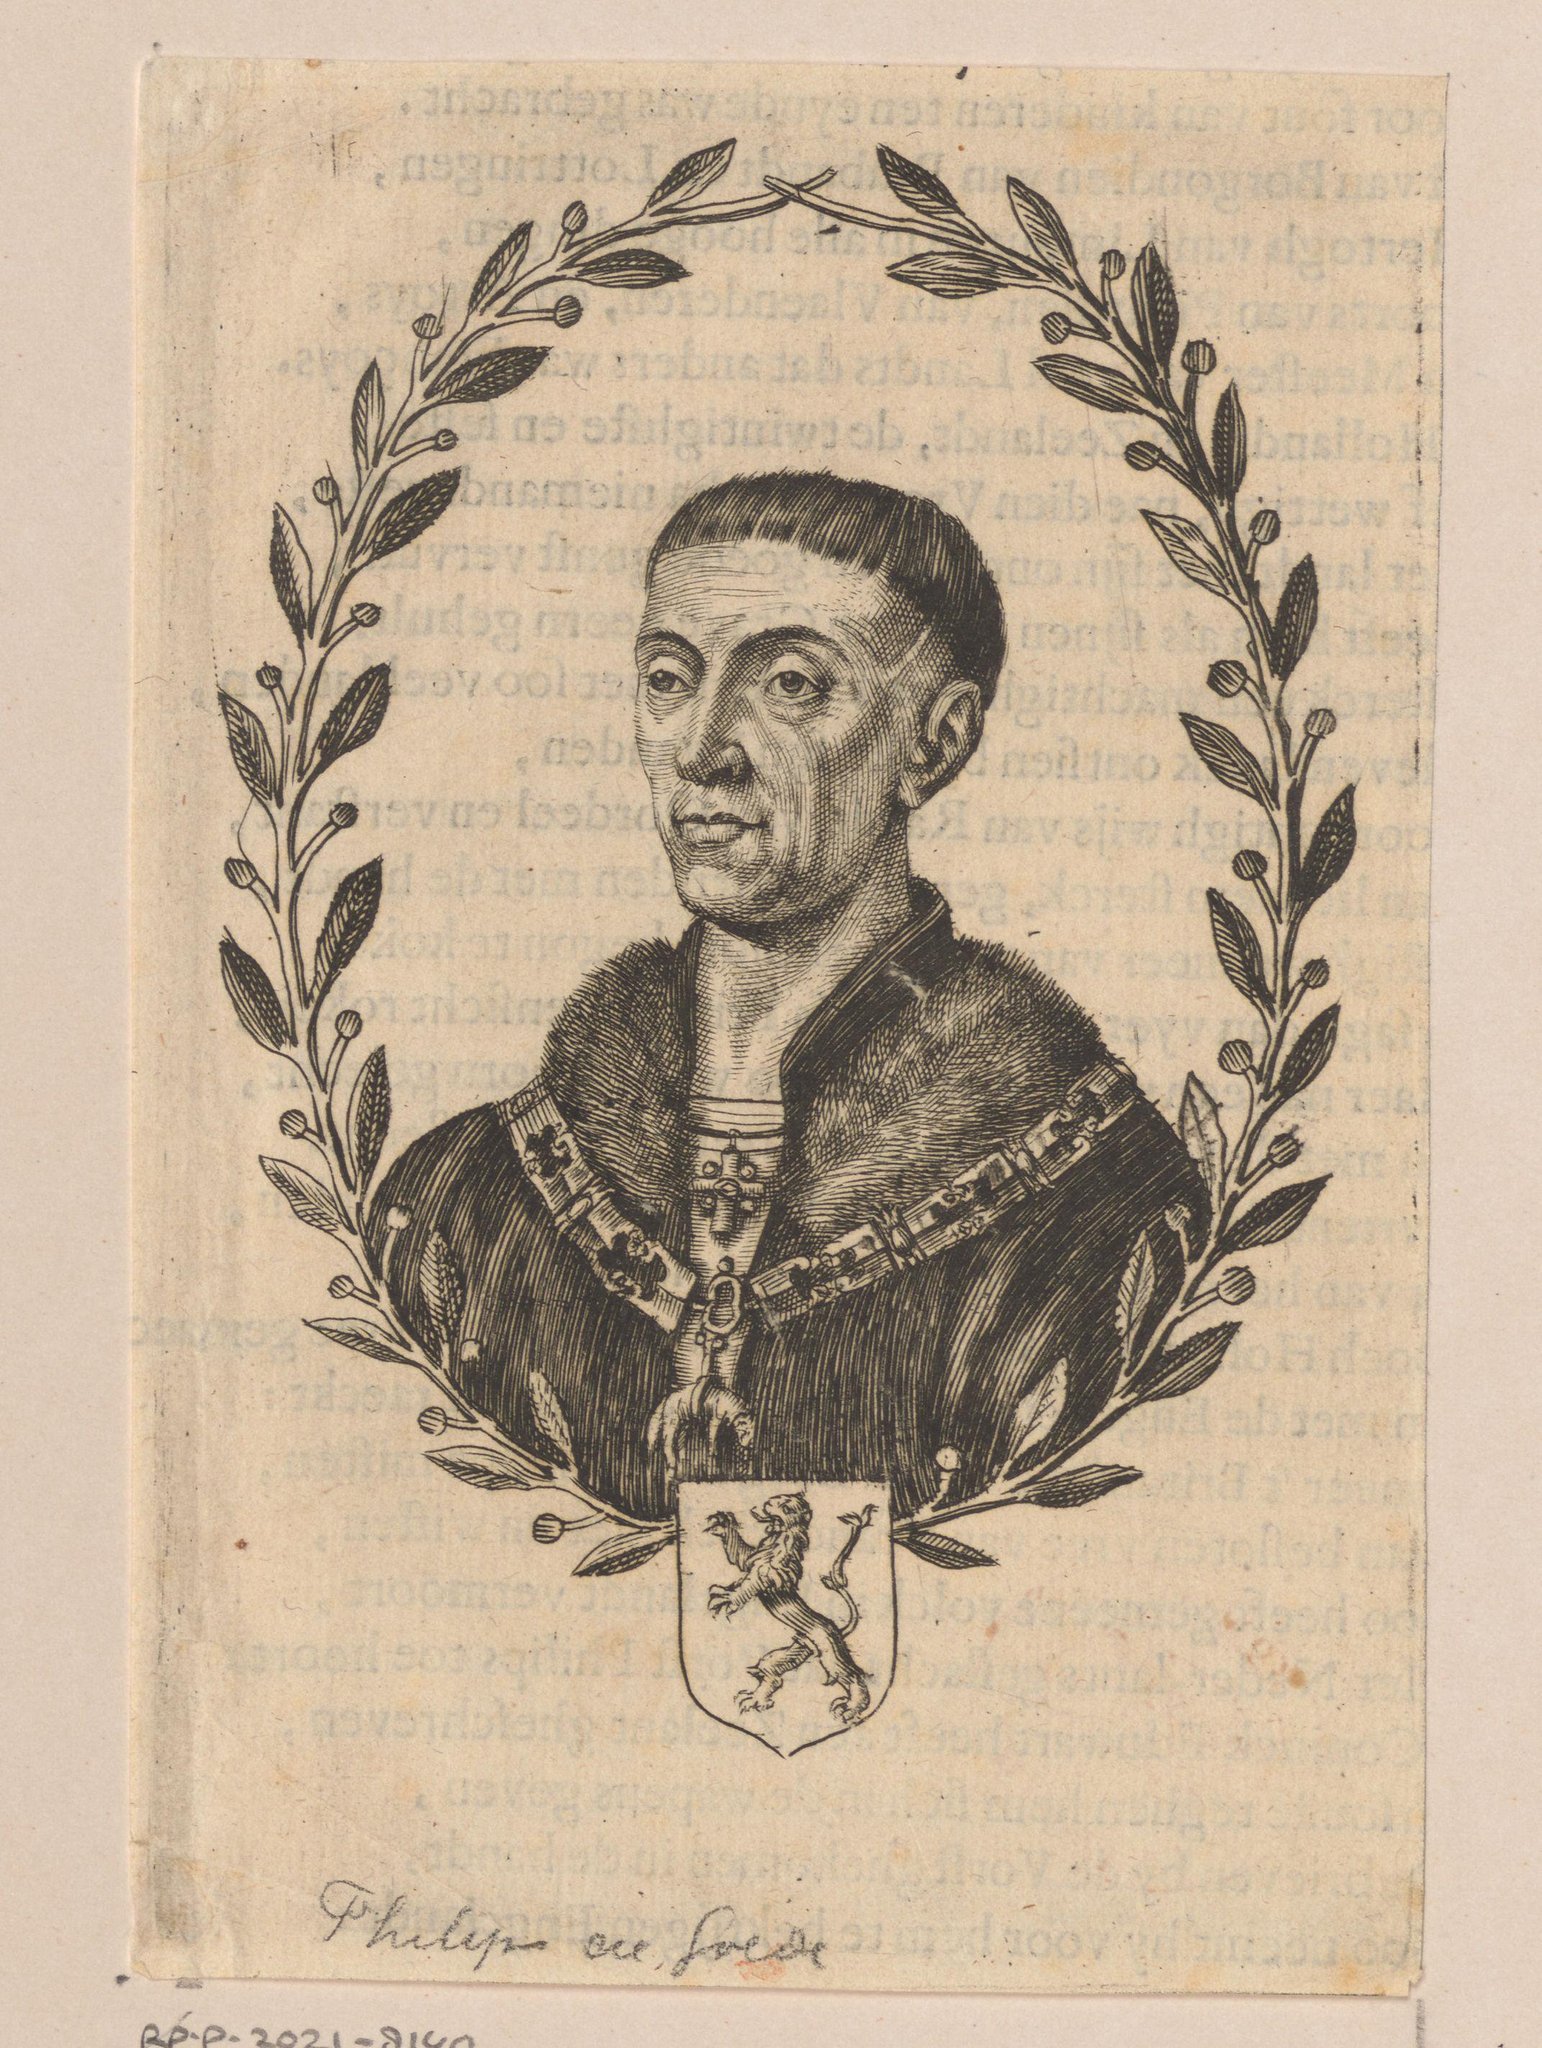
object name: print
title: Portret van Filips de Goede, hertog van Bourgondië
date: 1645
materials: paper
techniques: engraving, letterpress printing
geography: amsterdam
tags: philip iii the good, adult man, historical persons, armorial bearing, heraldry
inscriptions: collector's mark: Lugt 240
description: Prent uit: Wachtendorp, Casparus. Oude Hollandsche Geschiedenissen ofte, corte Rym-Kronyck verdeelt in XIIII Boecken, beginnende van de Suntvloet, tot den Jare 1560. Amsterdam: Johannes Pauli, 1645.